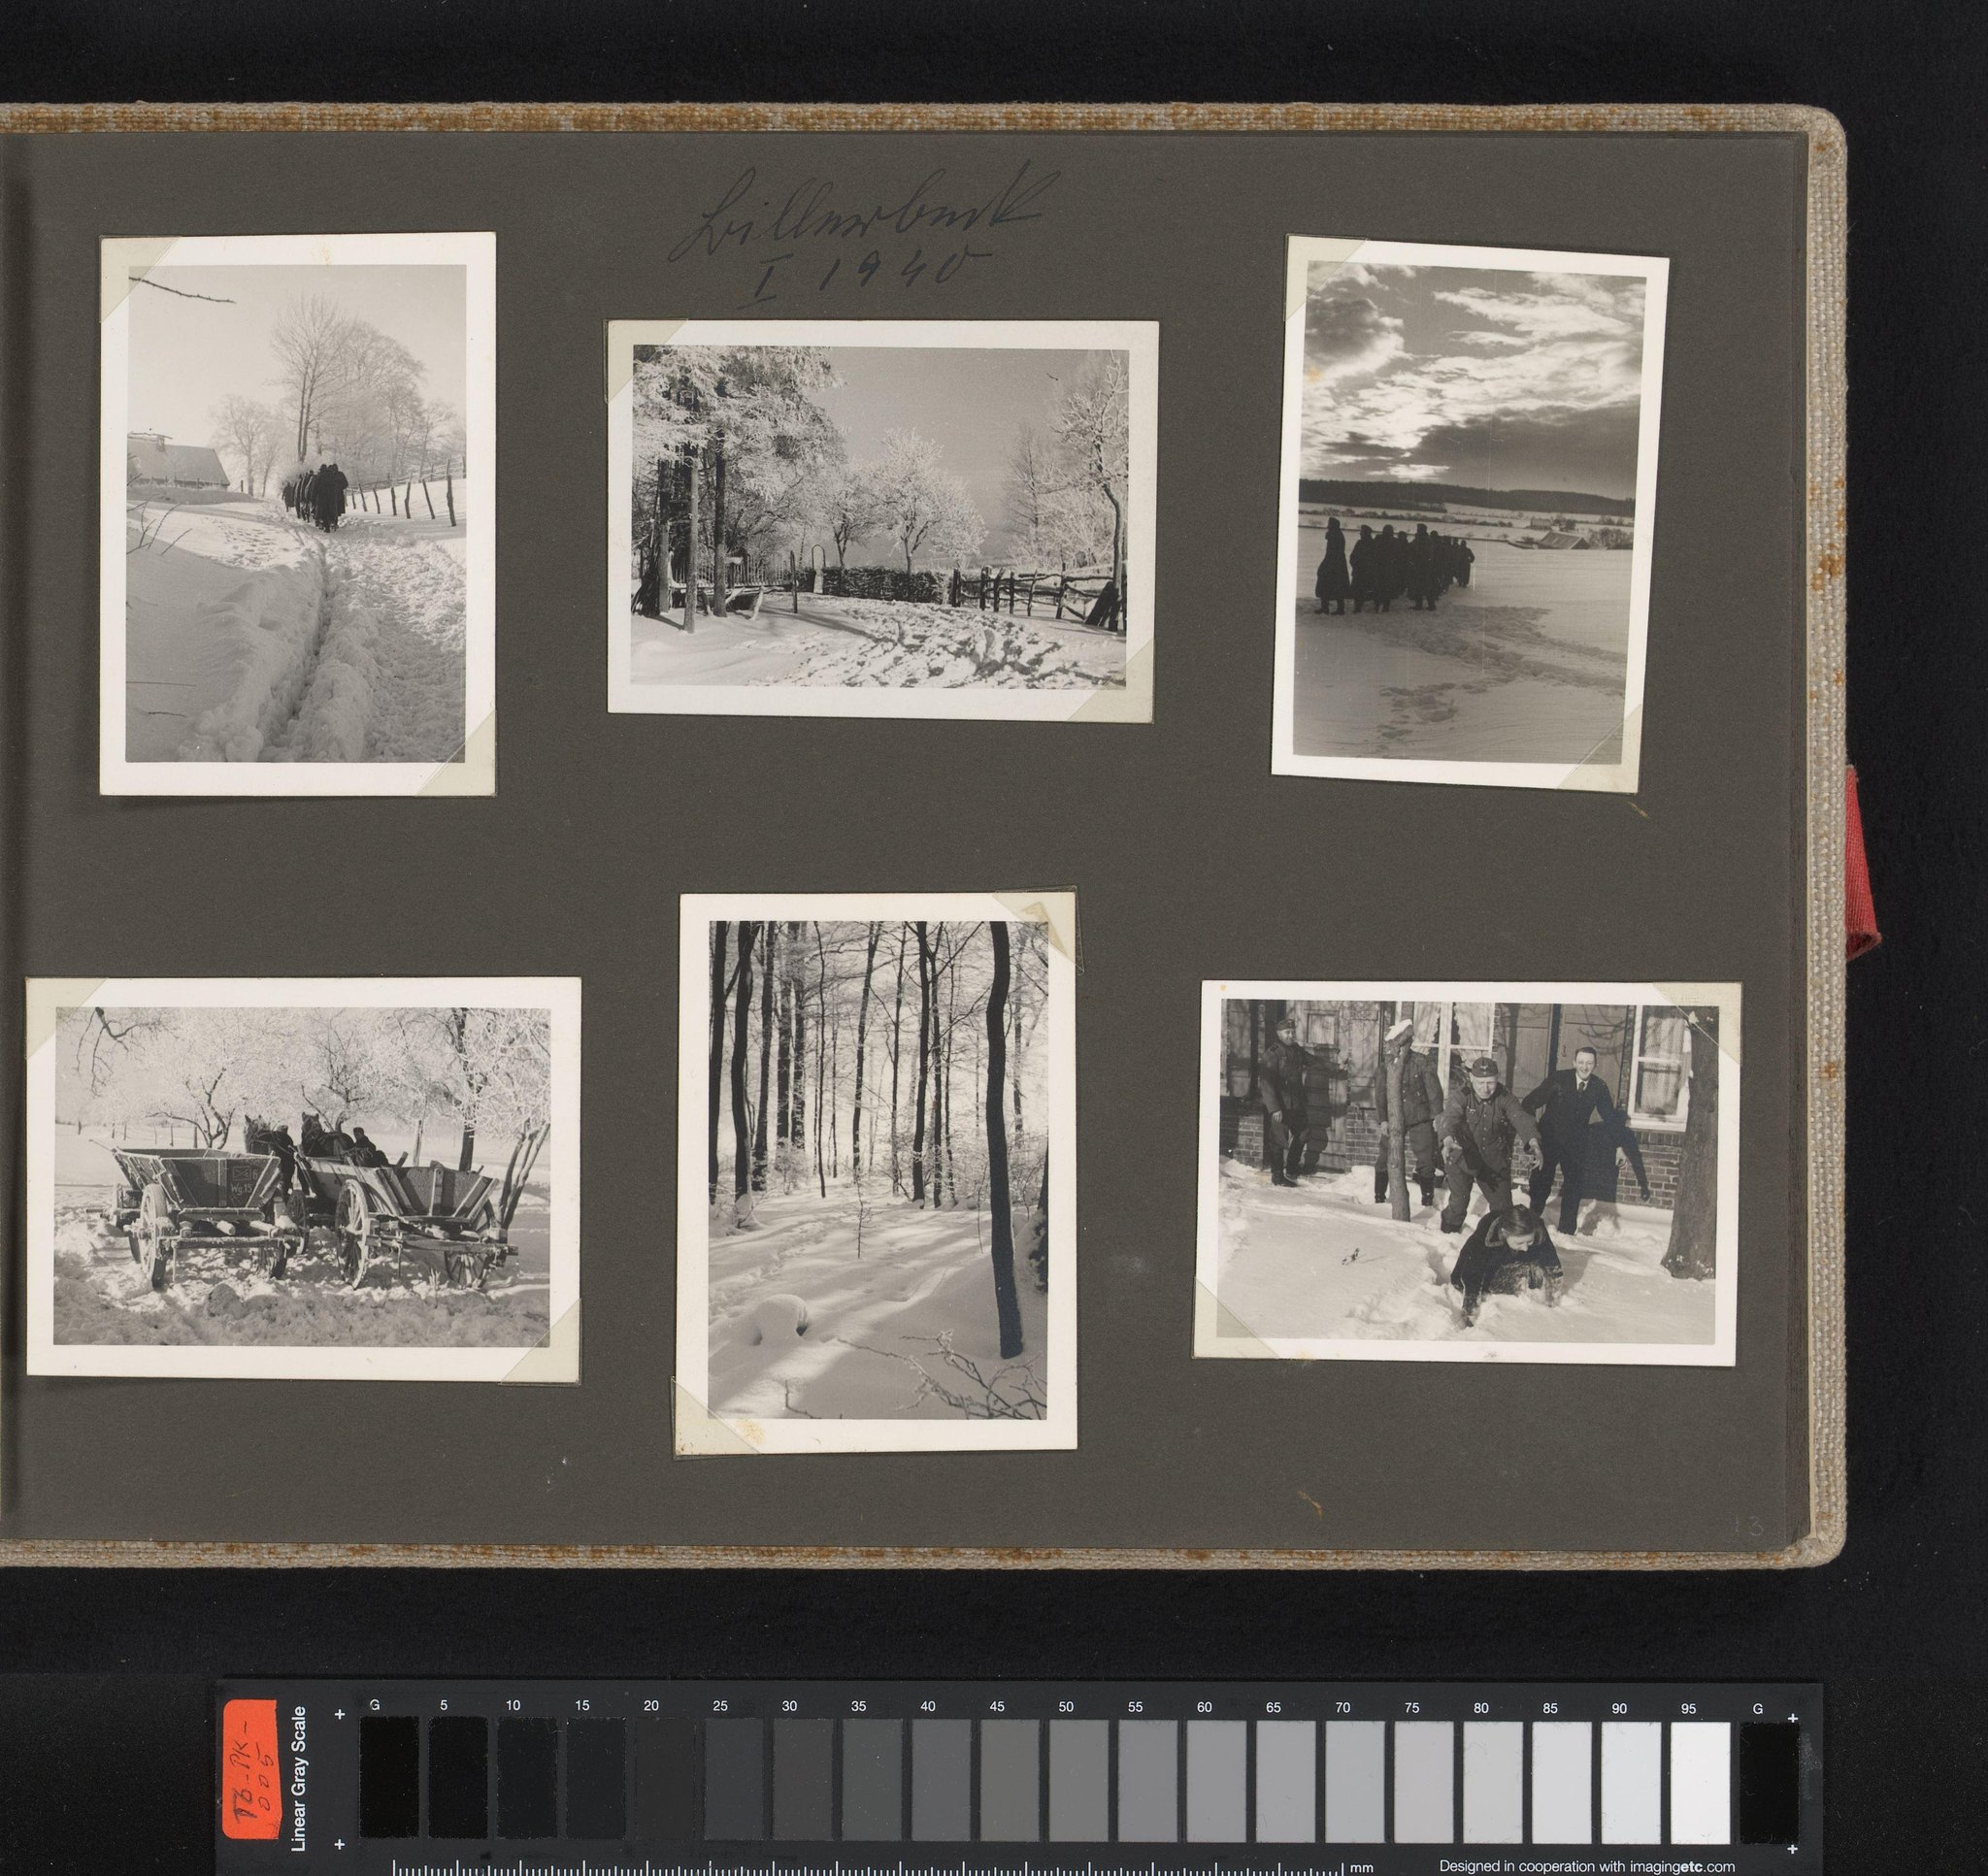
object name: photograph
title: Winter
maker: Anonymous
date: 1901-1940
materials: cardboard, photographic support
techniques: gelatin silver print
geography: germany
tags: the company, the unit, the troop ~ military service, military training, germany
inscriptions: inscription, inscription: ‘... I 1940’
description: Albumblad met zes foto's van werk en training van een groep militairen in de sneeuw, januari 1940. Onderdeel van de fotoalbum van de Wehrmacht 1938-1941.